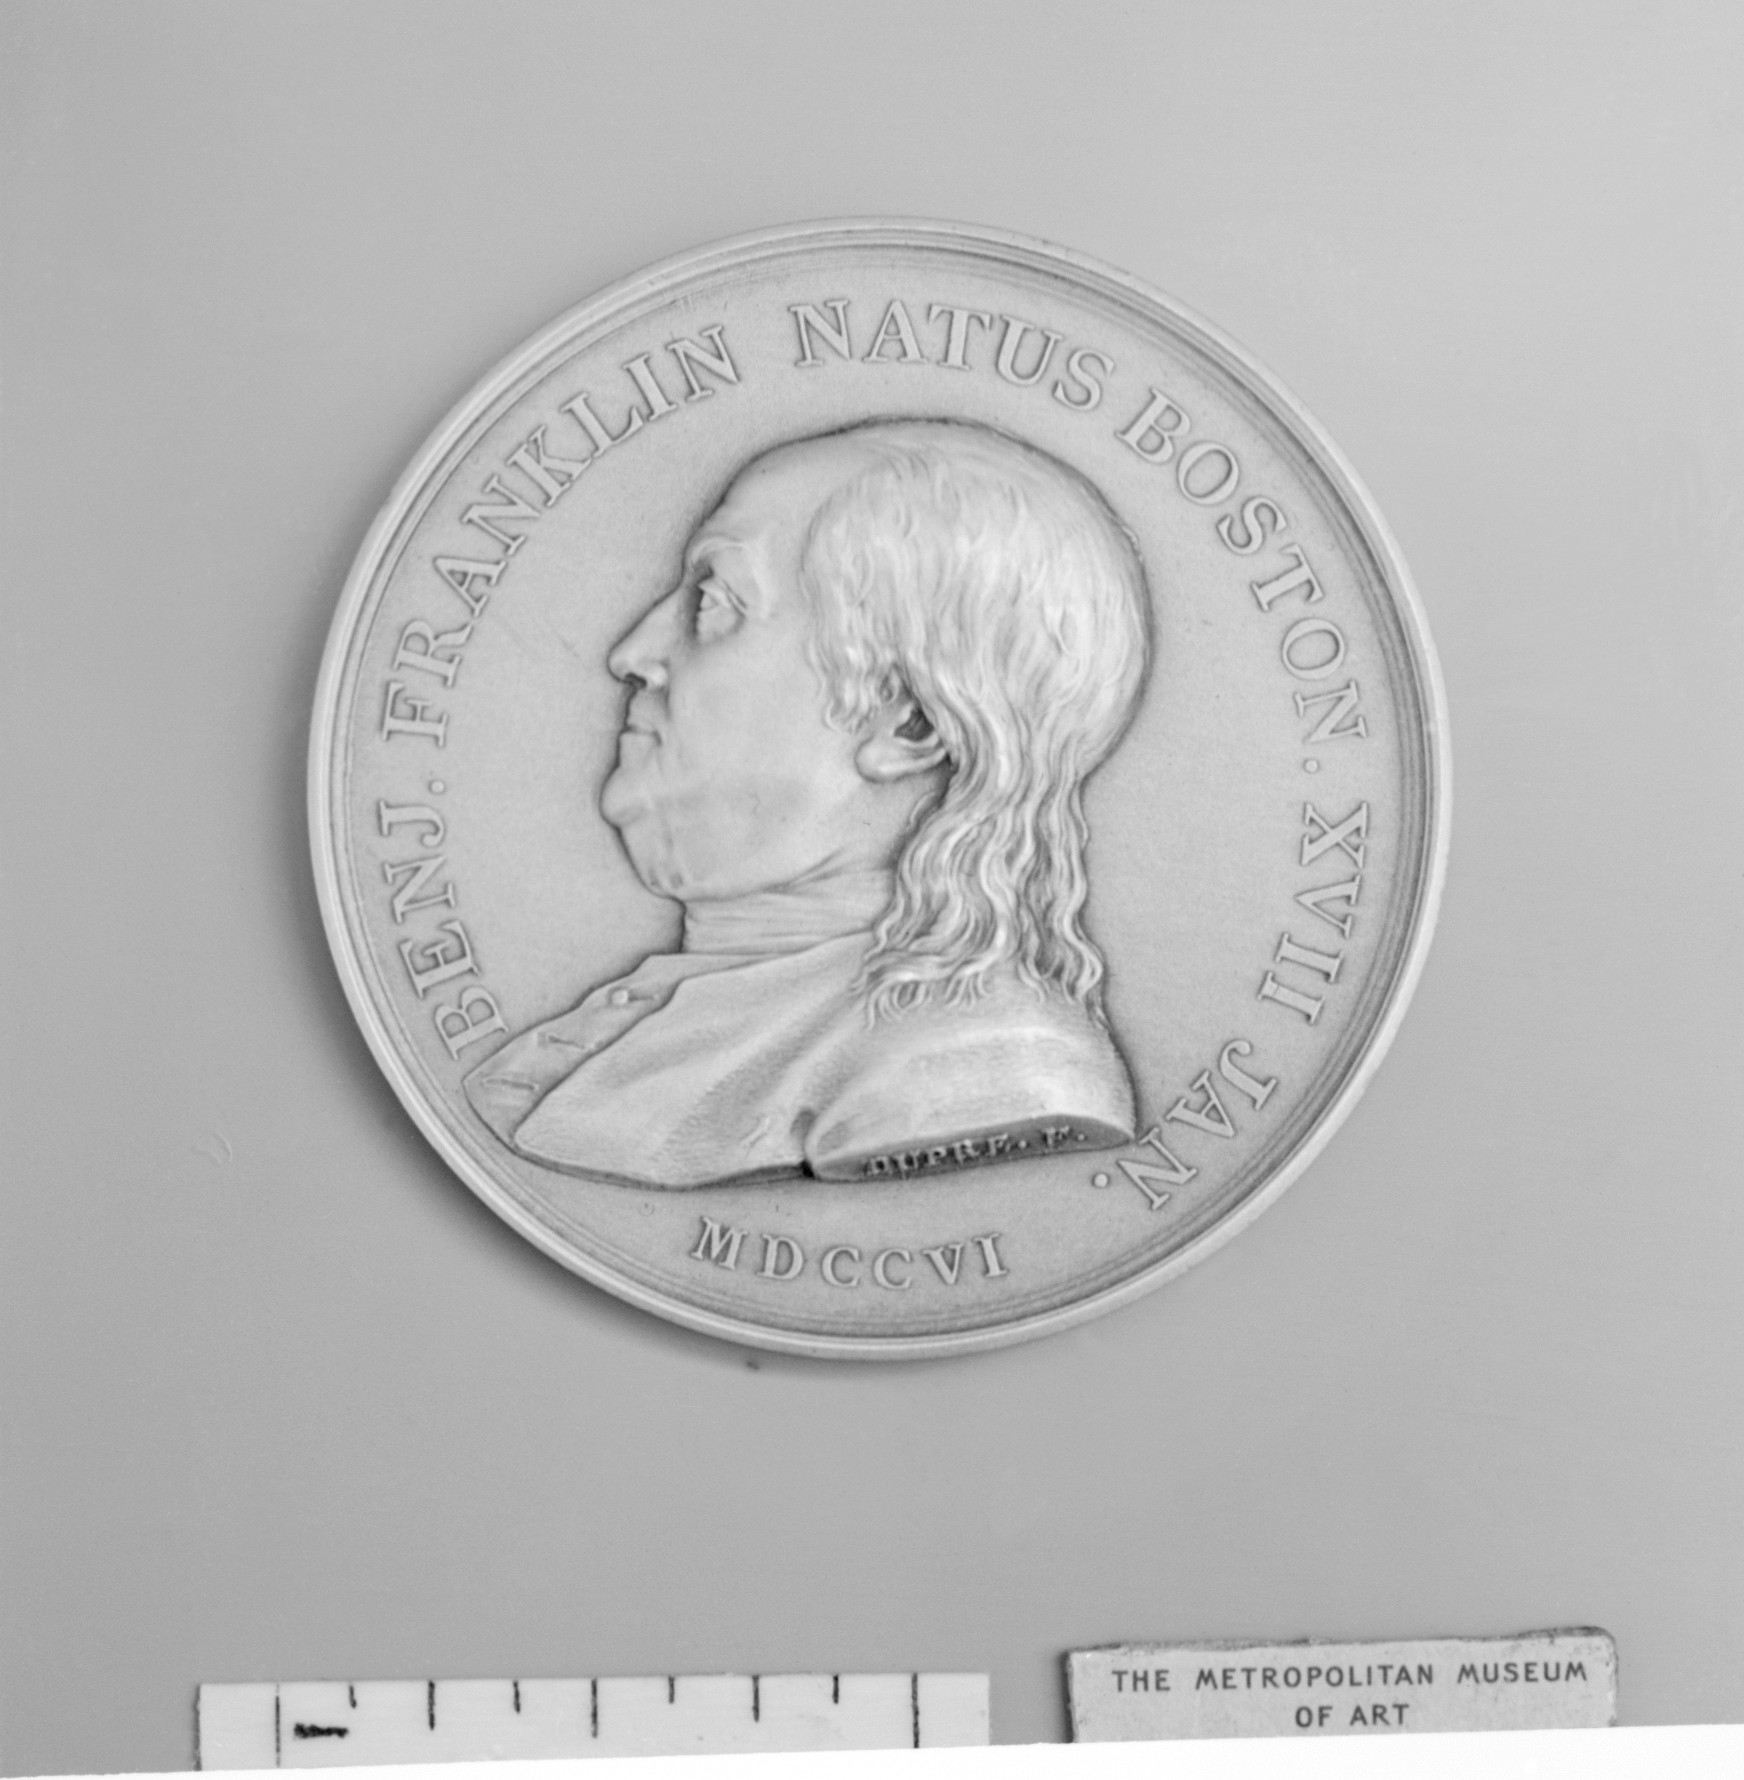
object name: medal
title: Benjamin Franklin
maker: augustin dupré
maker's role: artist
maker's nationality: french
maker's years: 1748-1833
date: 1784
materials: silver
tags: benjamin franklin,profiles